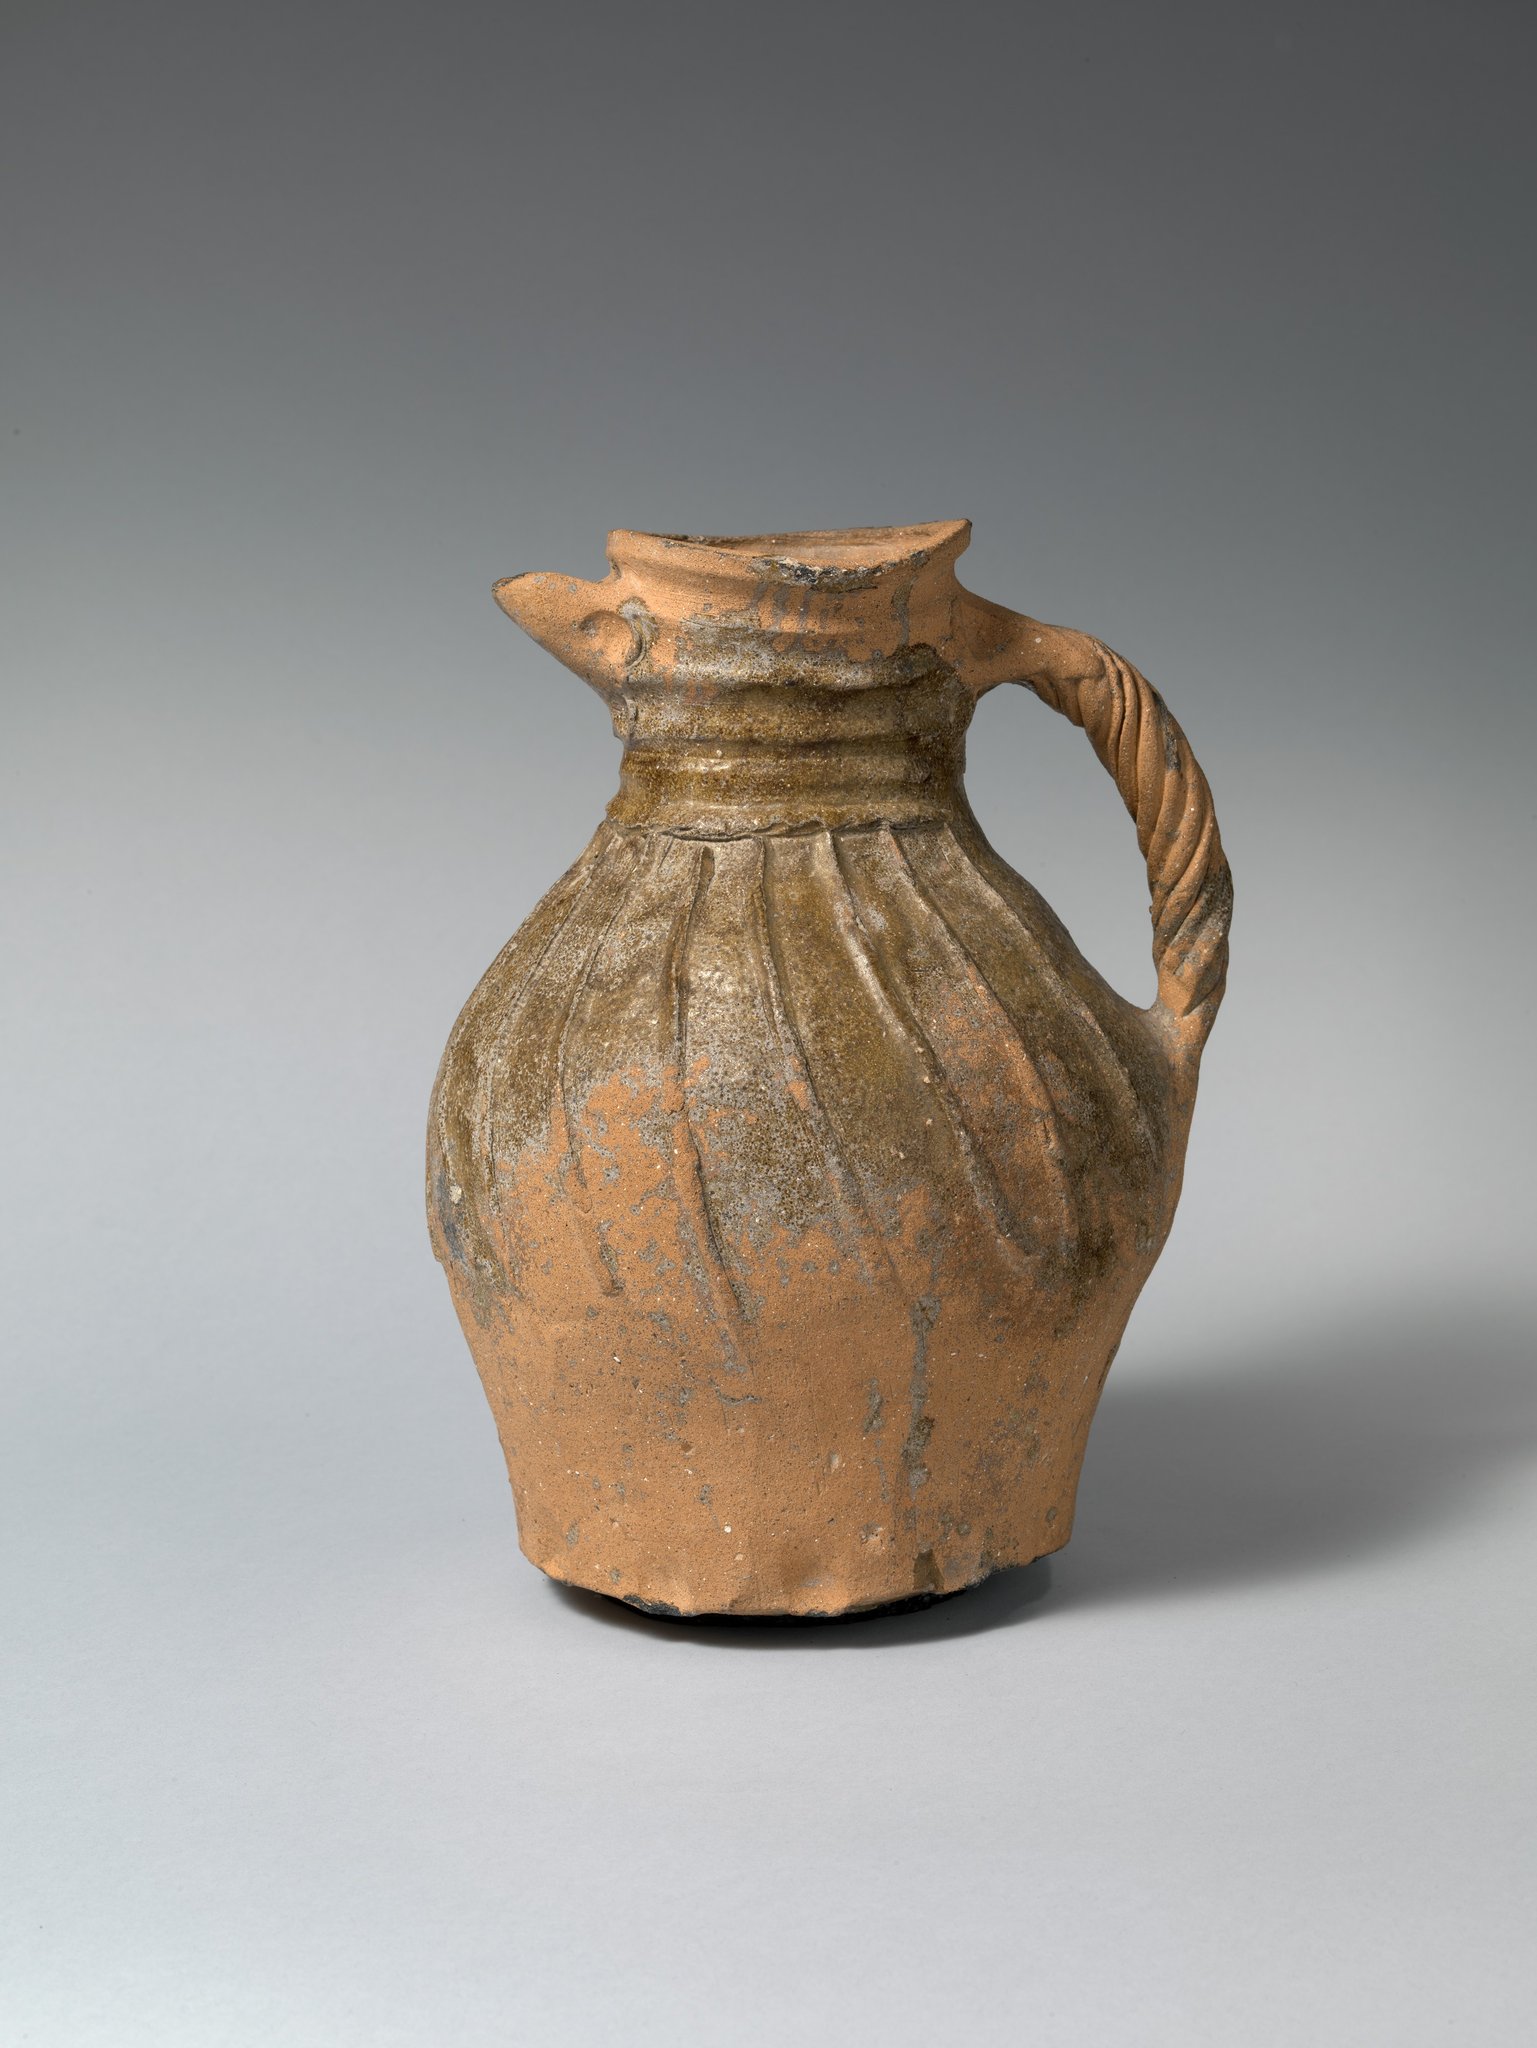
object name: jug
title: Jug with twisted handle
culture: british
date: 1267-1300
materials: earthenware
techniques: glazing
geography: england